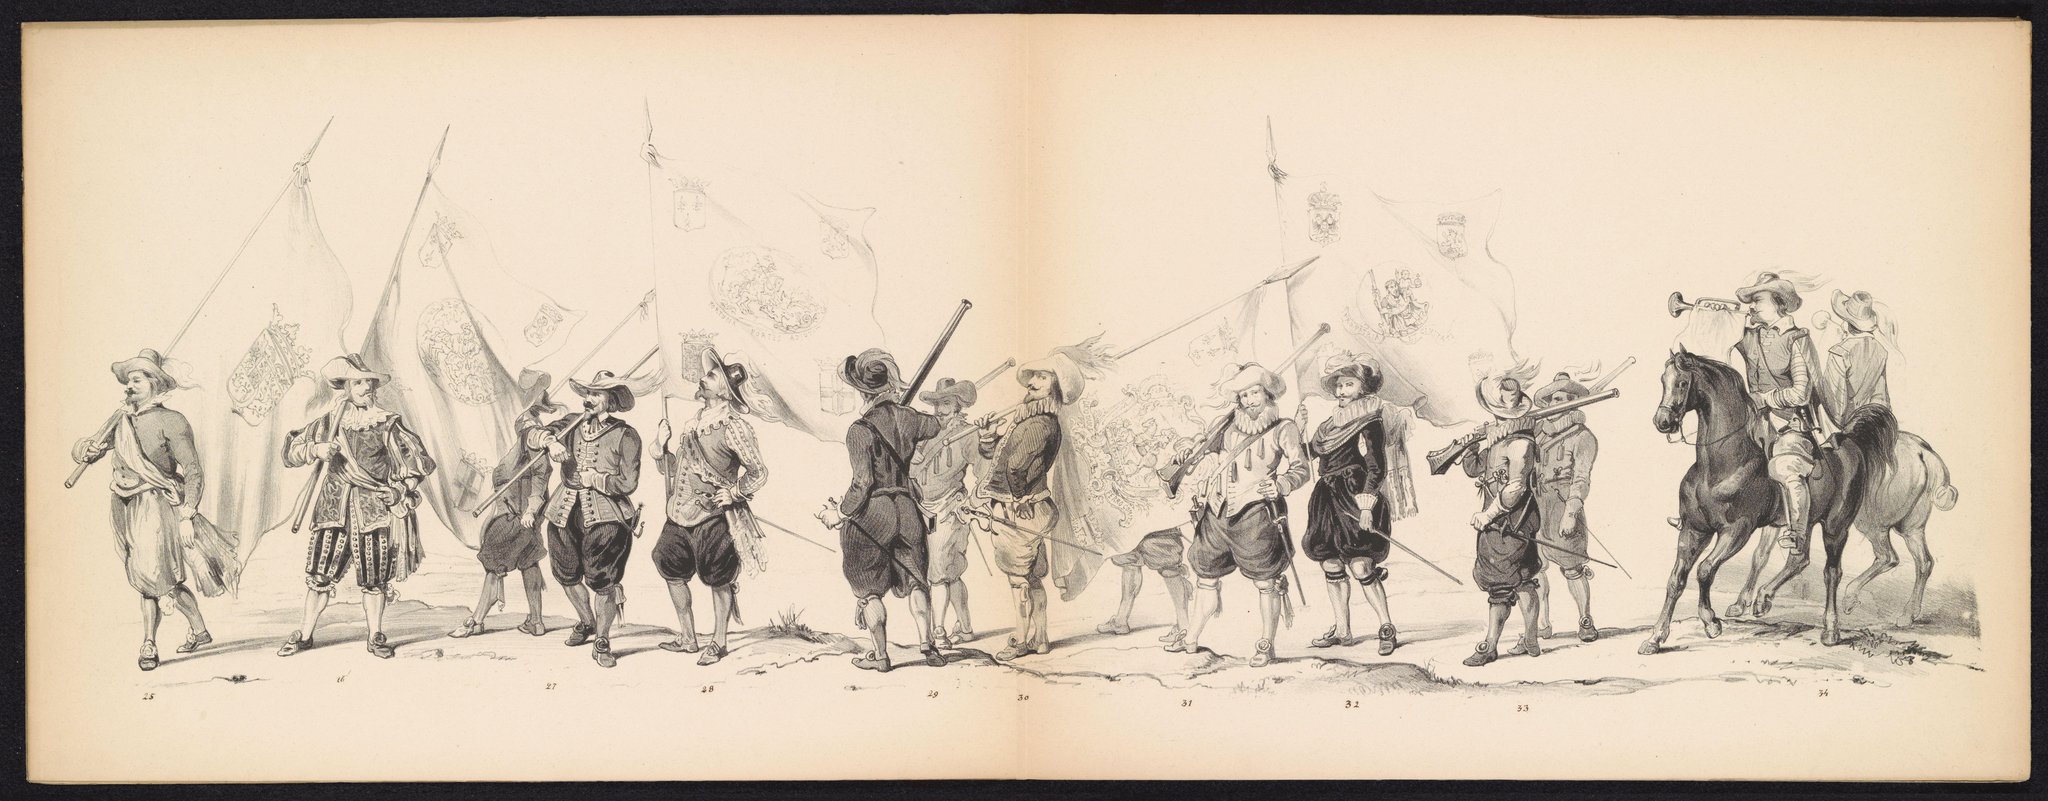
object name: text sheet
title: Maskerade van de Leidse studenten, 1850 (plaat 3)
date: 1850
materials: paper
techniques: lithograph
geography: the hague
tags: delft, frederick henry (prince of orange), students' pageant, costumes used in pageants, leiden, den bosch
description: Historische gekostumeerde optocht van de studenten van de Leidse Hogeschool op 11 juni 1850. De optocht verbeeldt de intocht van Frederik Hendrik te Den Bosch in 1629. Derde plaat met de groepen genummerd 25-34. Onderdeel van de serie van dertien aanelkaar geplakte bladen.